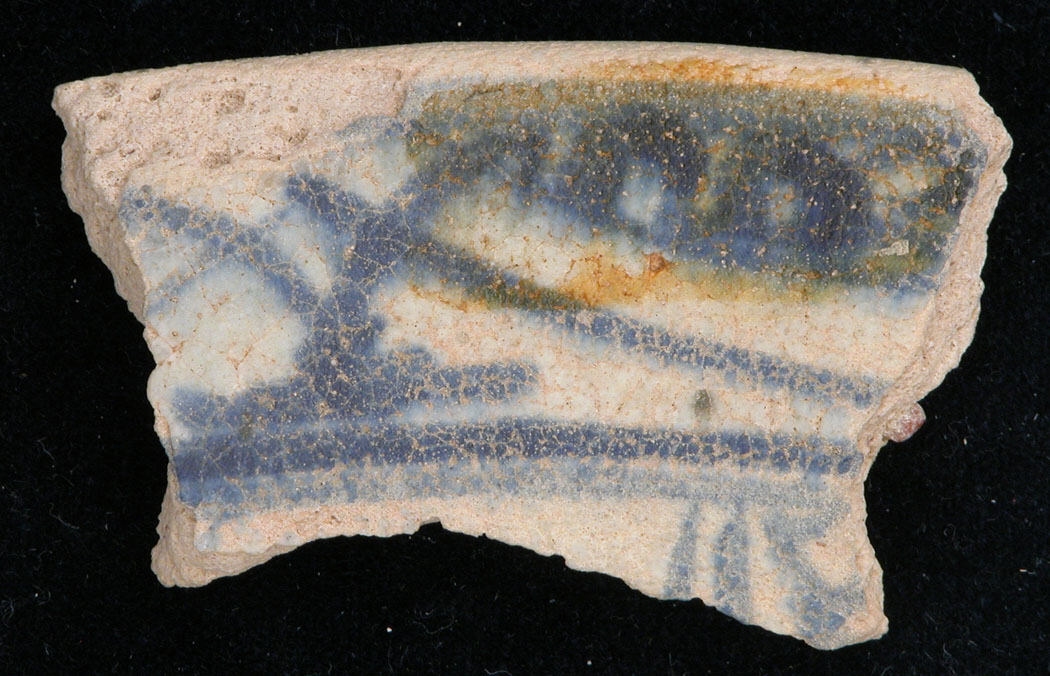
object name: fragment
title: Ceramic Fragment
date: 1201-1600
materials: stonepaste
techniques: glazing, painting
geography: saudi arabia